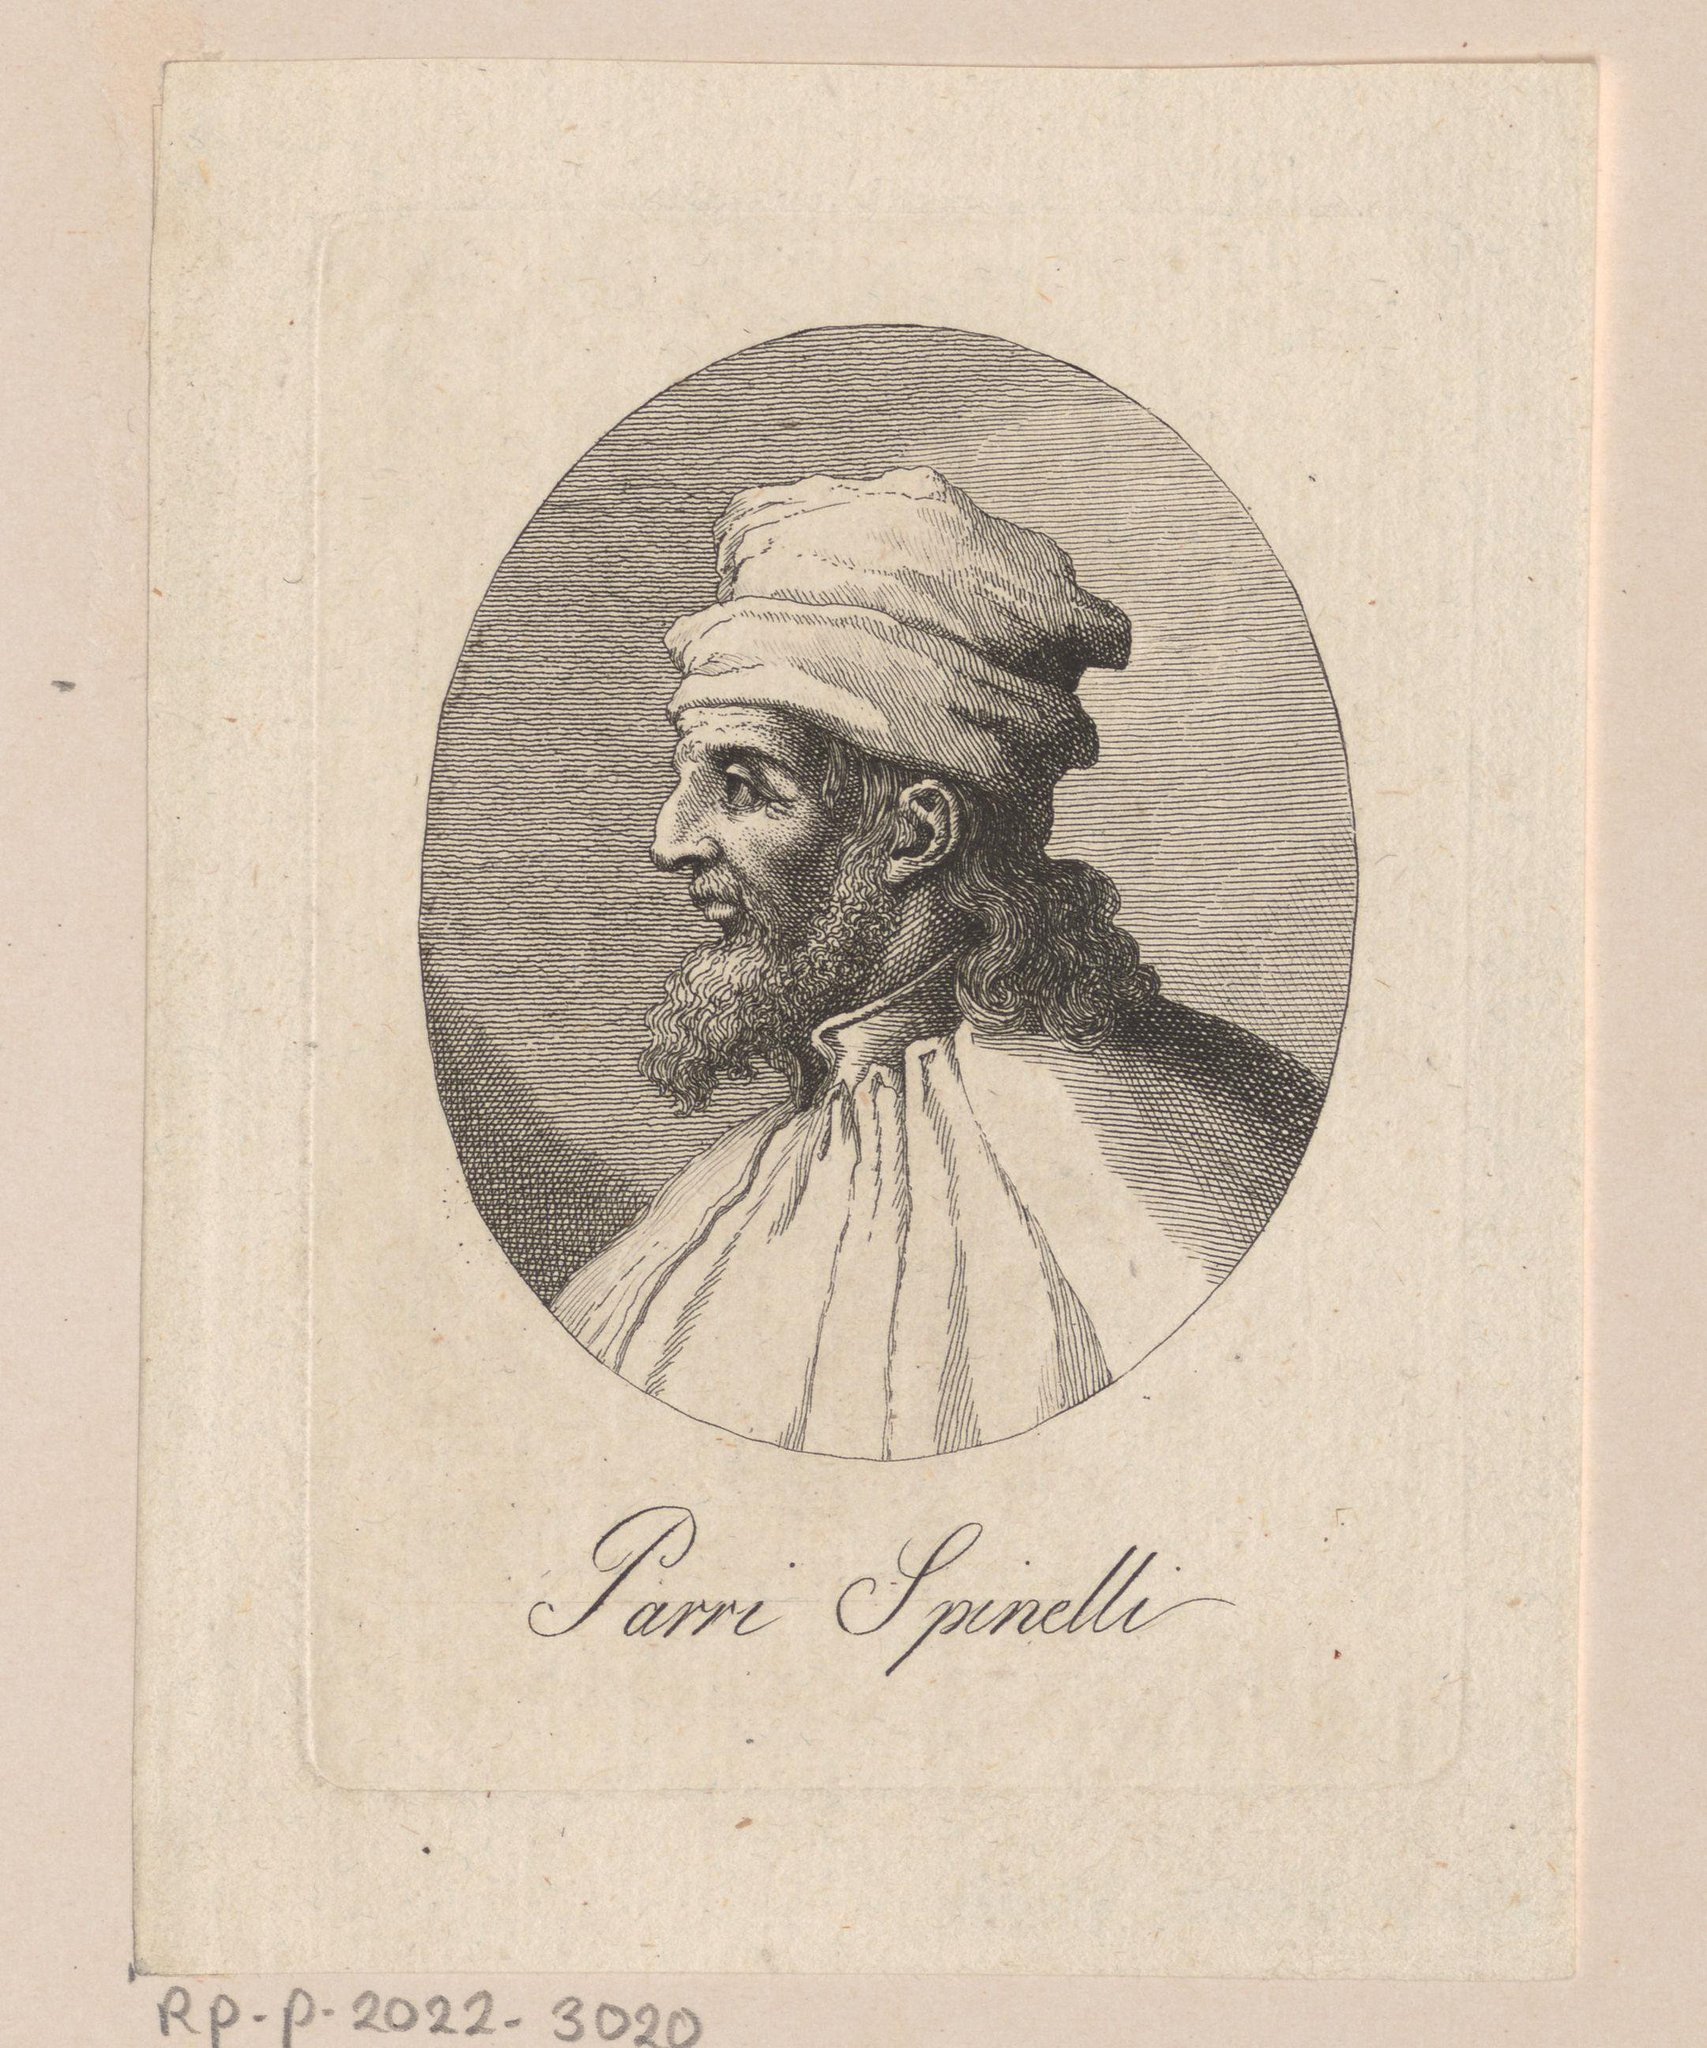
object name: print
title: Portret van Parri Spinelli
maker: Anonymous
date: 1650-1799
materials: paper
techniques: etching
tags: painter, historical persons, portrait, self-portrait of artist